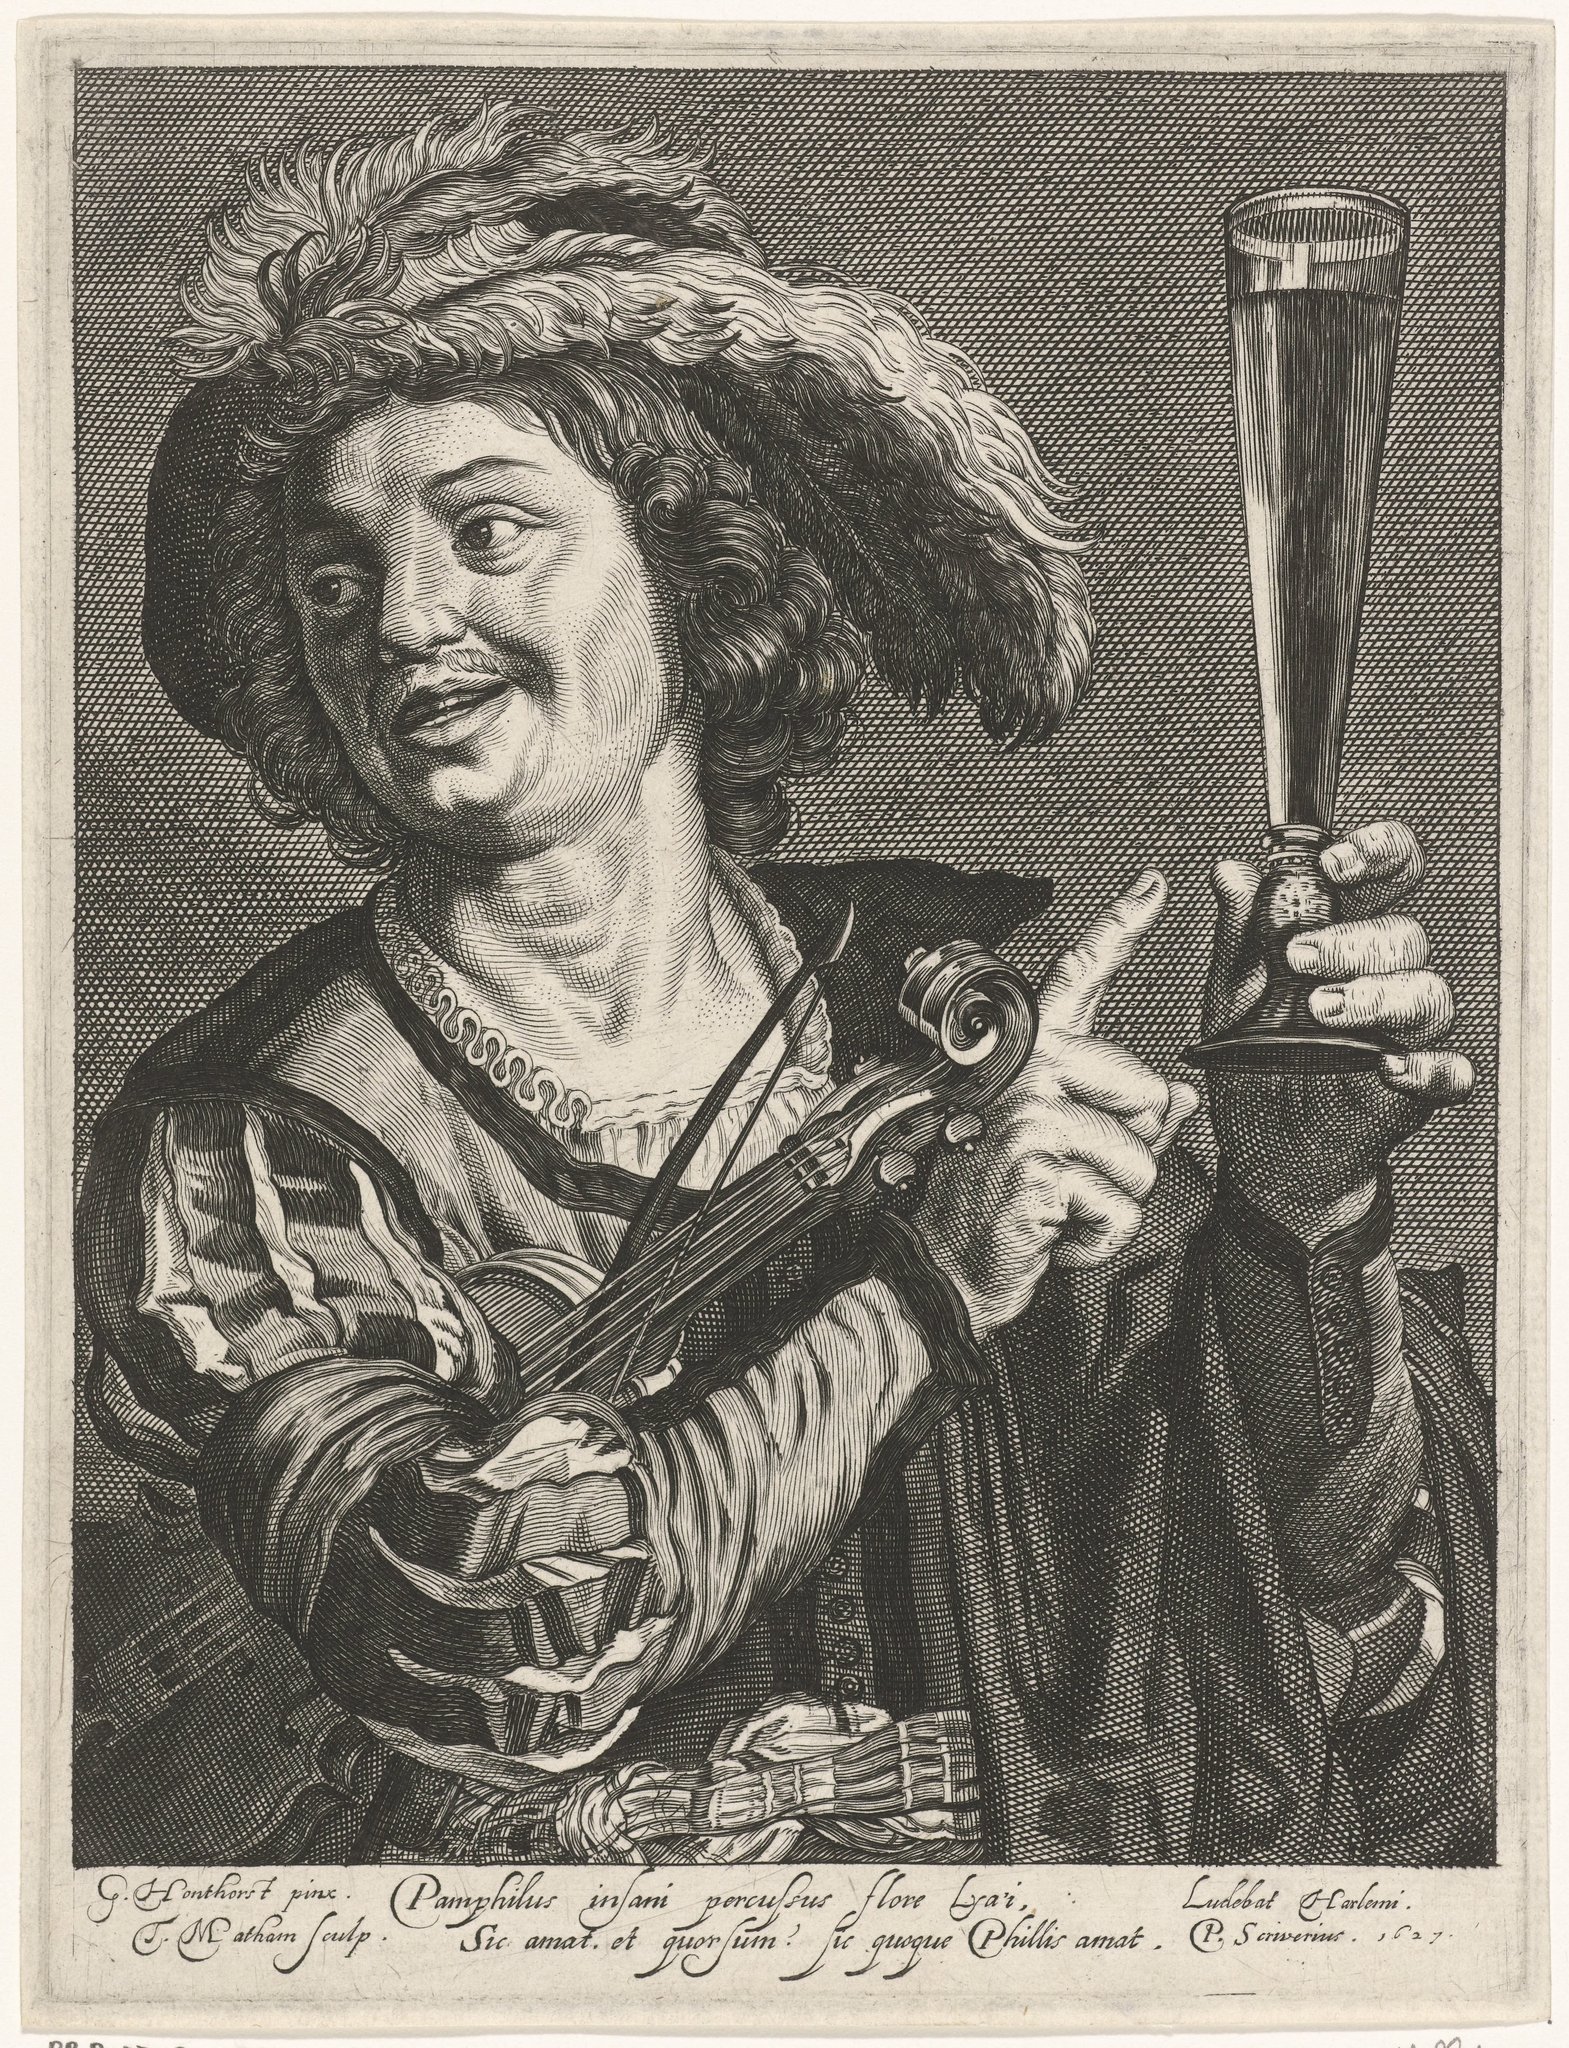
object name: print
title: Man wijst naar glas in linkerhand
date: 1627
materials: paper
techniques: engraving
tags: violin, fiddle, glass, rummer, glass of wine, one person with musical instrument, not playing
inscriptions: collector's mark: Lugt 240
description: Een man met een viool en een strijkstok onder zijn arm wijst naar een fluitglas in zijn linkerhand.